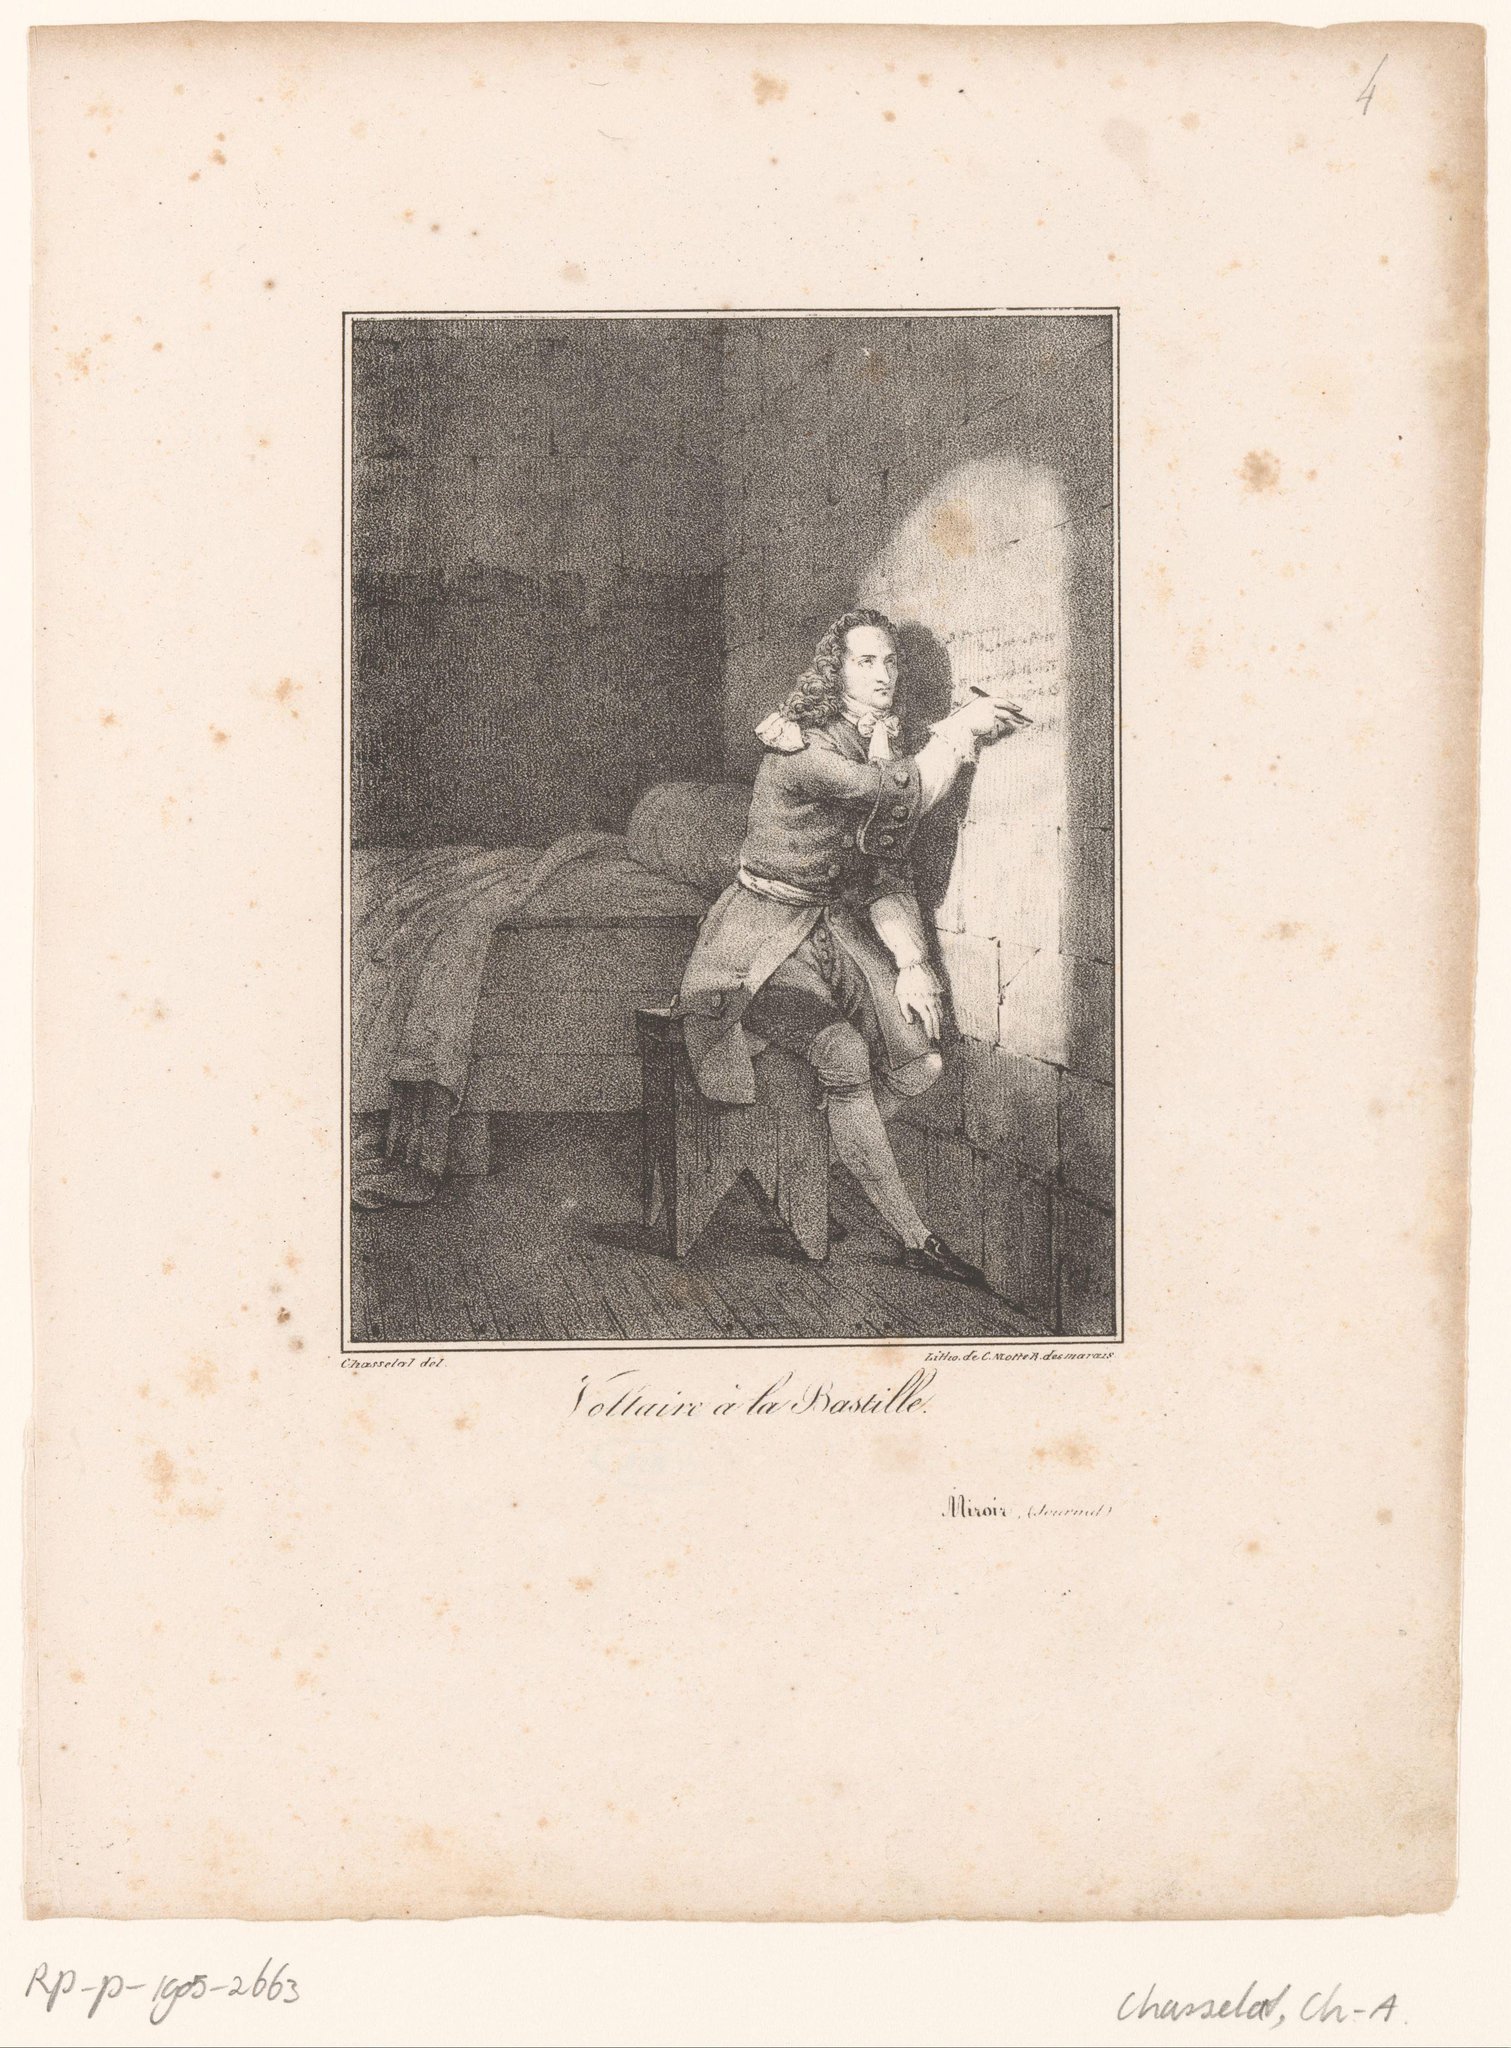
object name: print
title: Voltaire schrijft op de muur van zijn cel in de Bastille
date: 1820-1833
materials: paper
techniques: lithograph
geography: paris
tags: paris, voltaire, sandwich-man, historical persons, writing and letters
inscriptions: collector's mark: Lugt 2228a, number: ‘4’